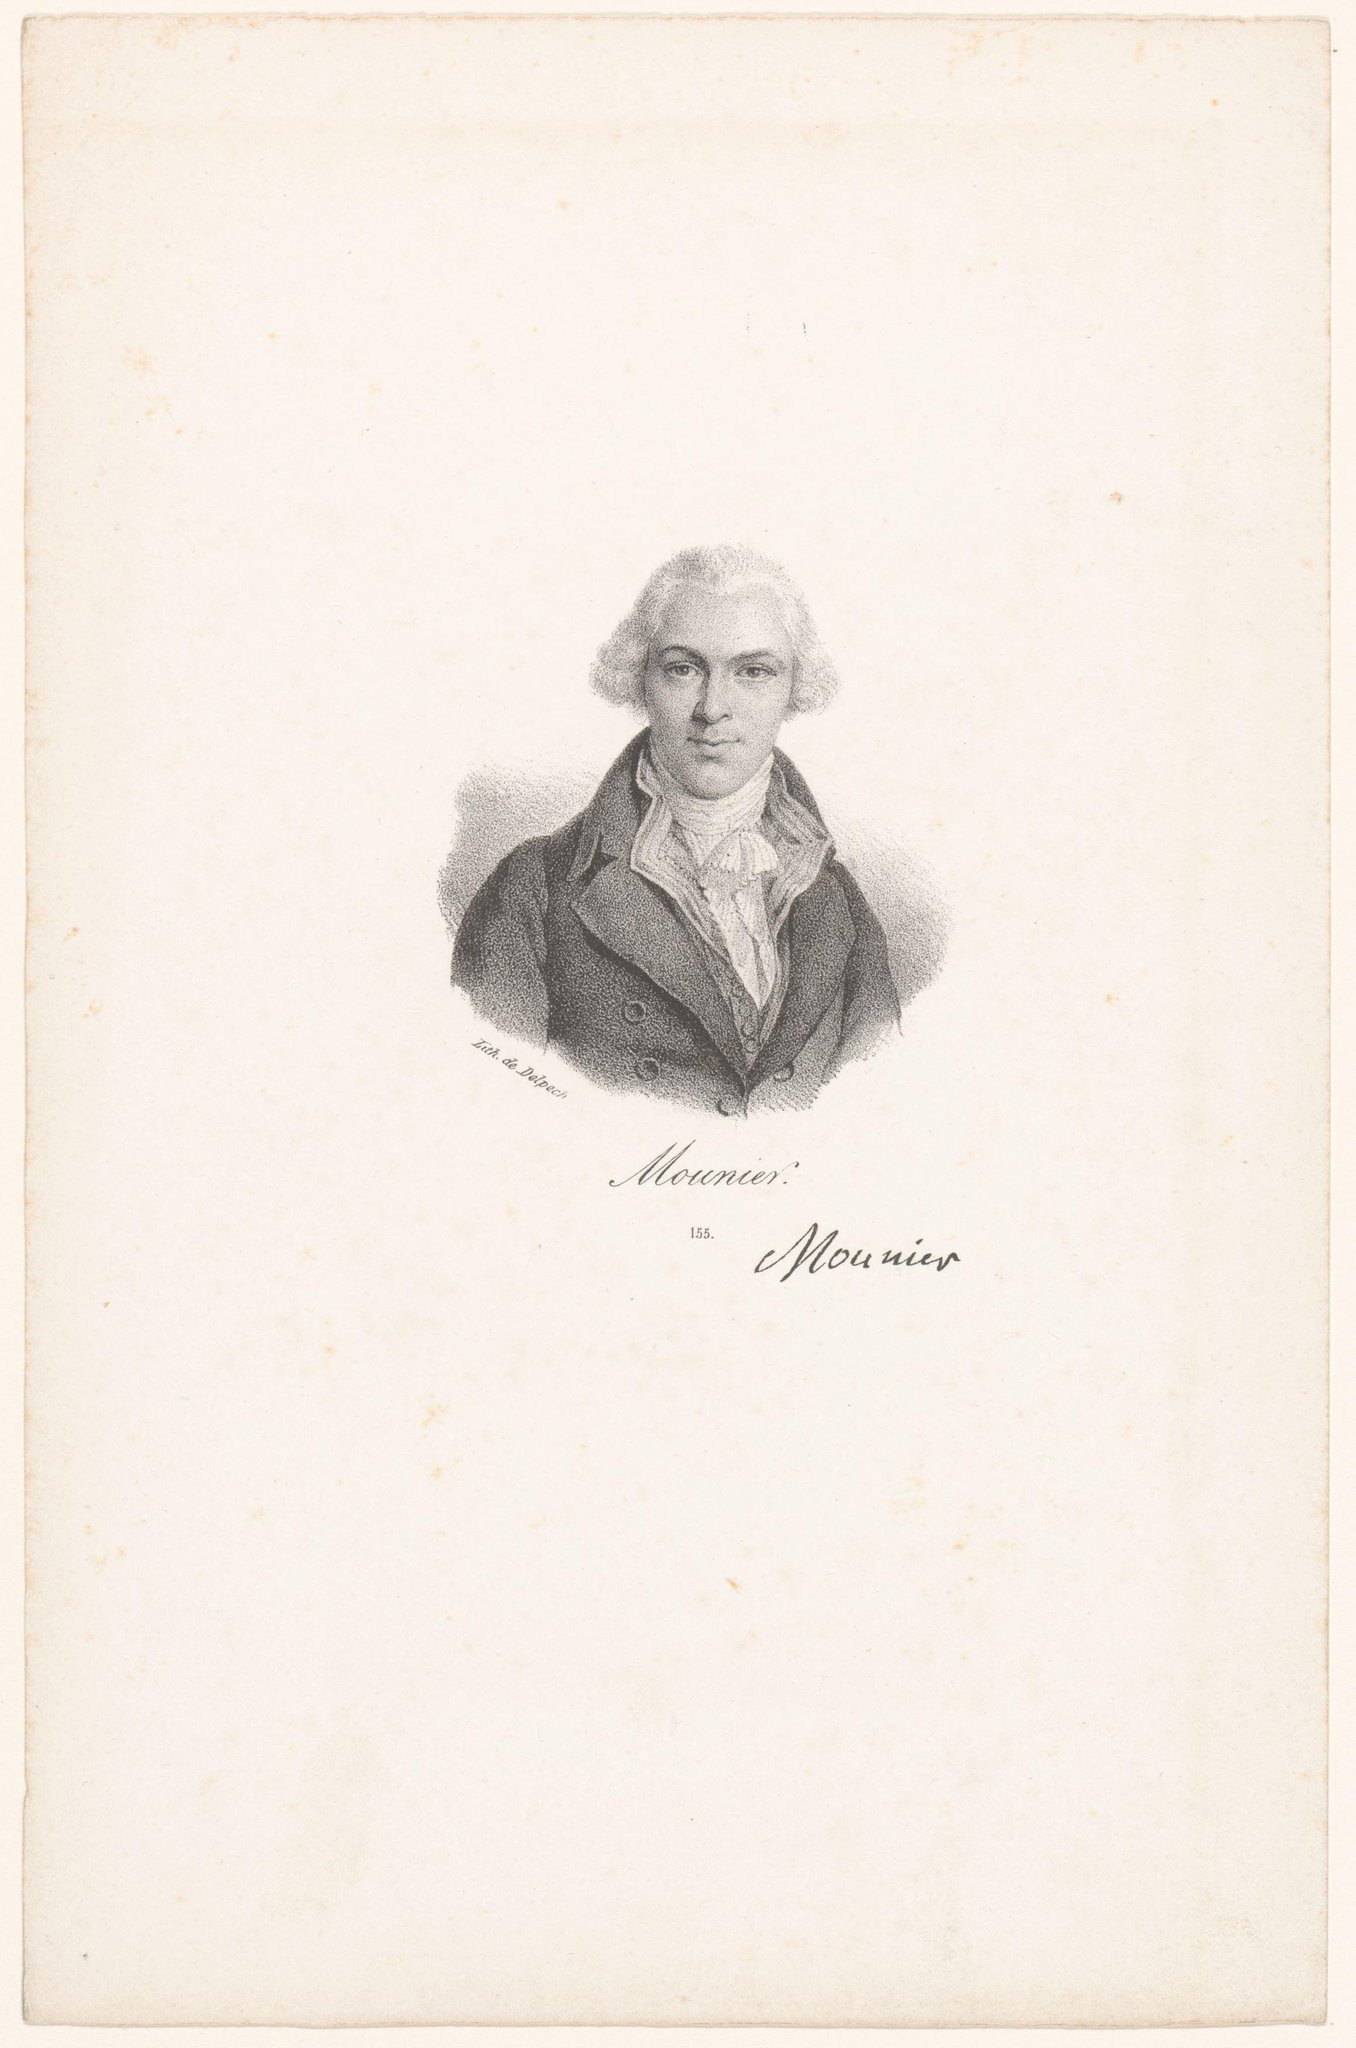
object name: print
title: Mounier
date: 1818-1842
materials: paper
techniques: lithograph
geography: paris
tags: historical persons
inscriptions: collector's mark: Lugt 2228a